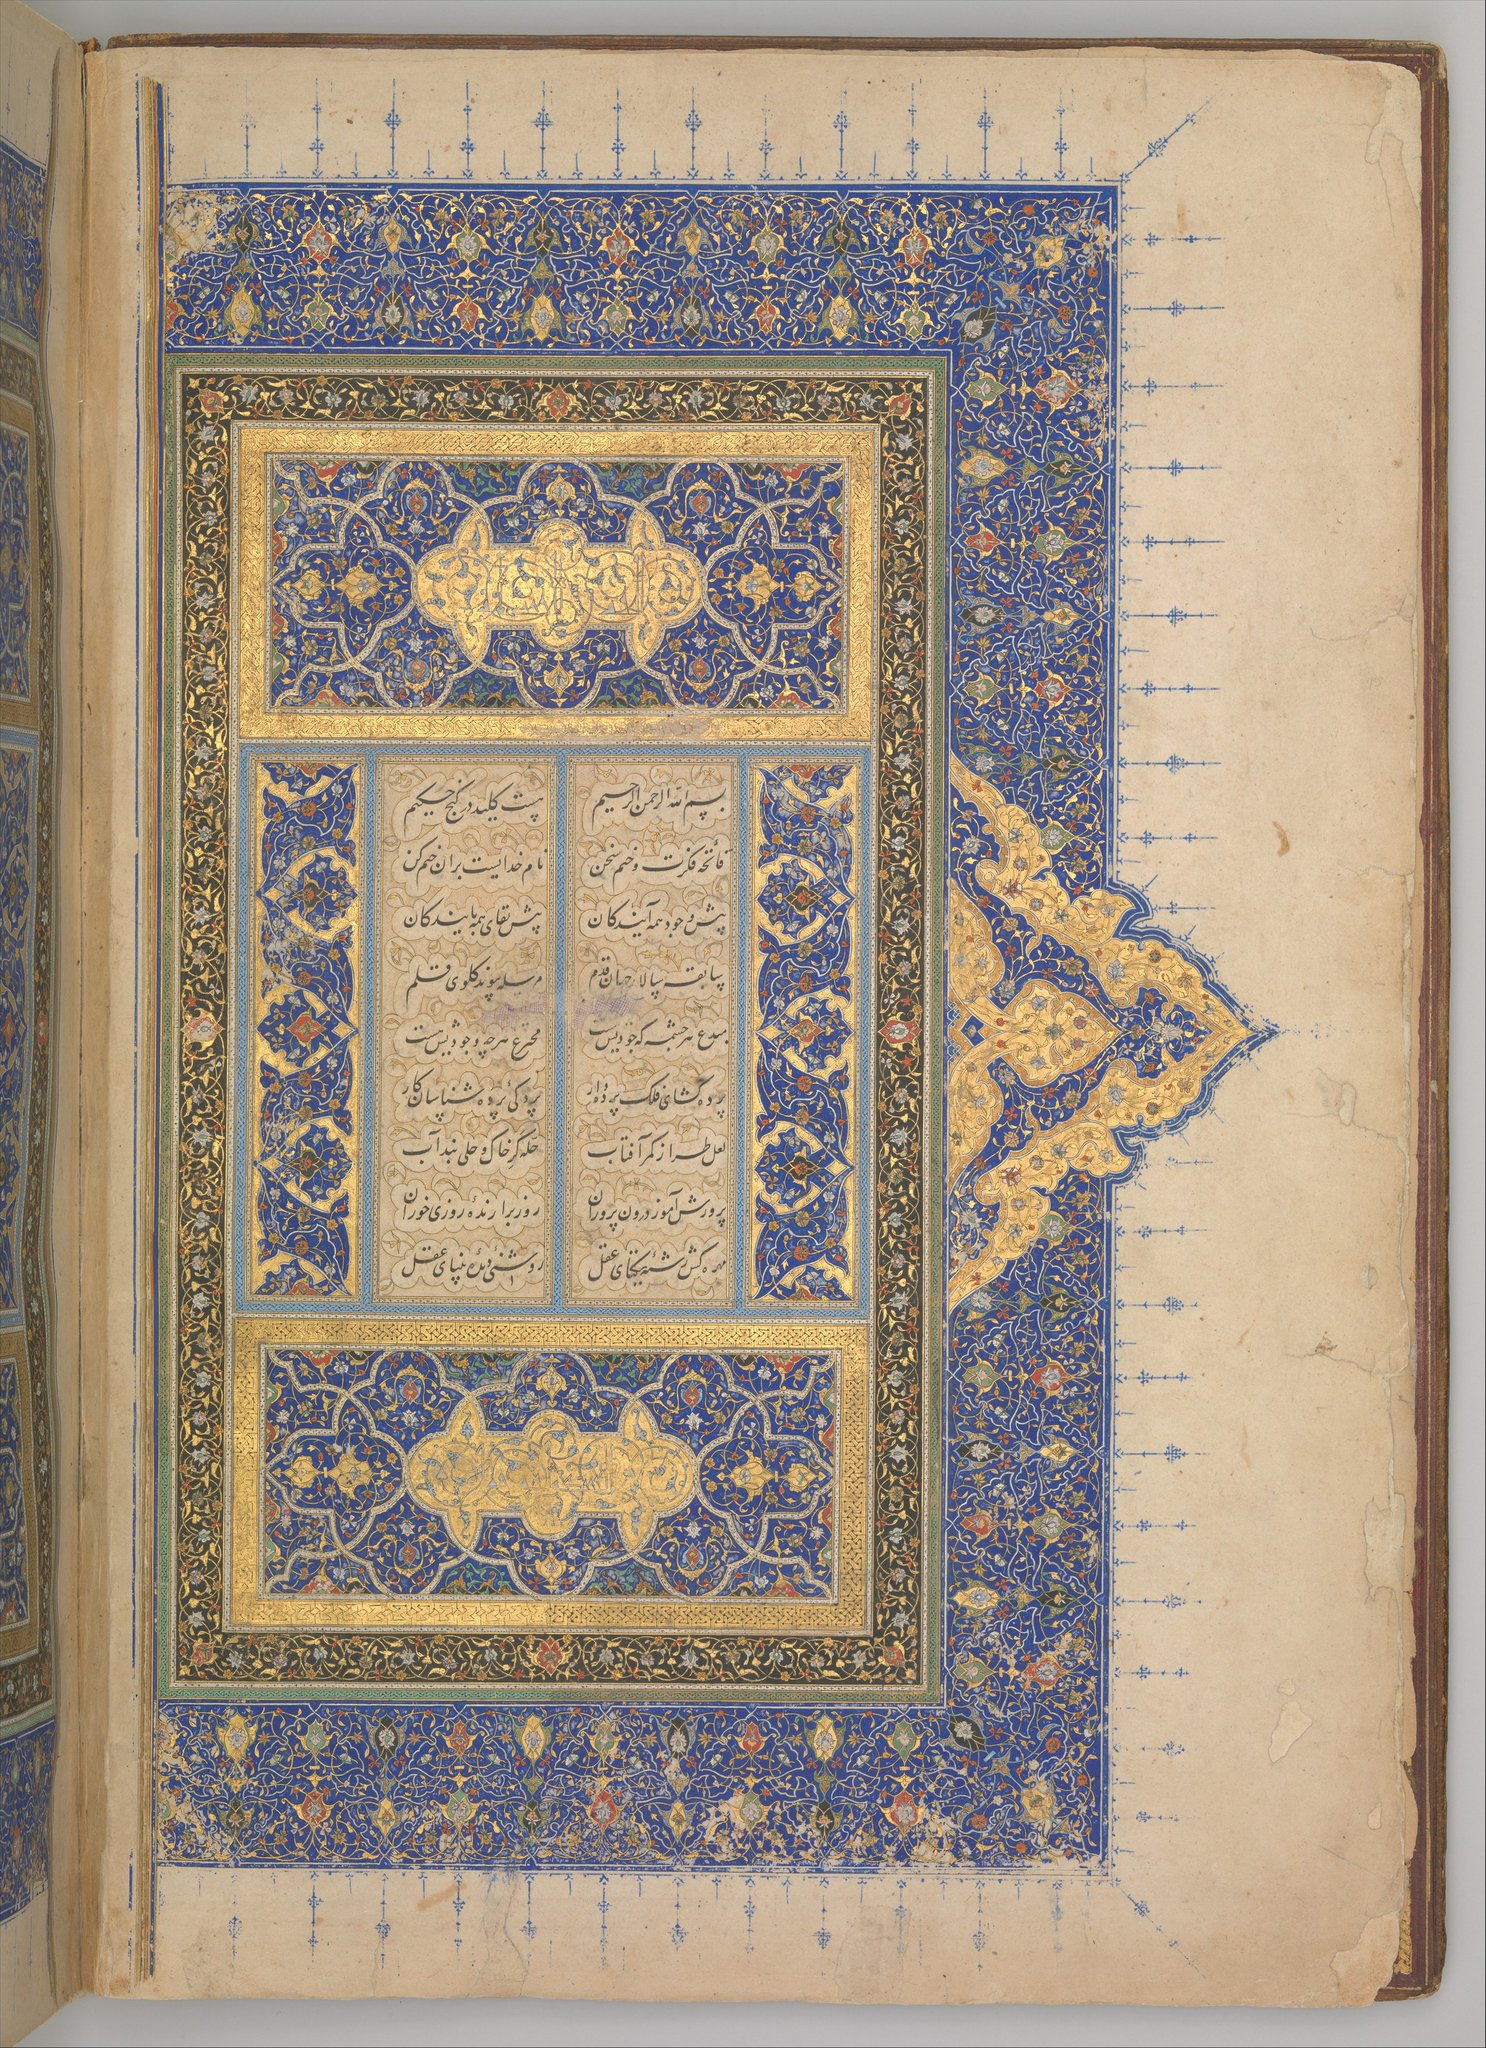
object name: illustrated manuscript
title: Overflap and Inside Cover of a Khamsa (Quintet) of Nizami of Ganja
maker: nizami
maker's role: author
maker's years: 1141-1209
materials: gold, ink, leather, paper, watercolor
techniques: bookbinding, embossing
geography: afghanistan